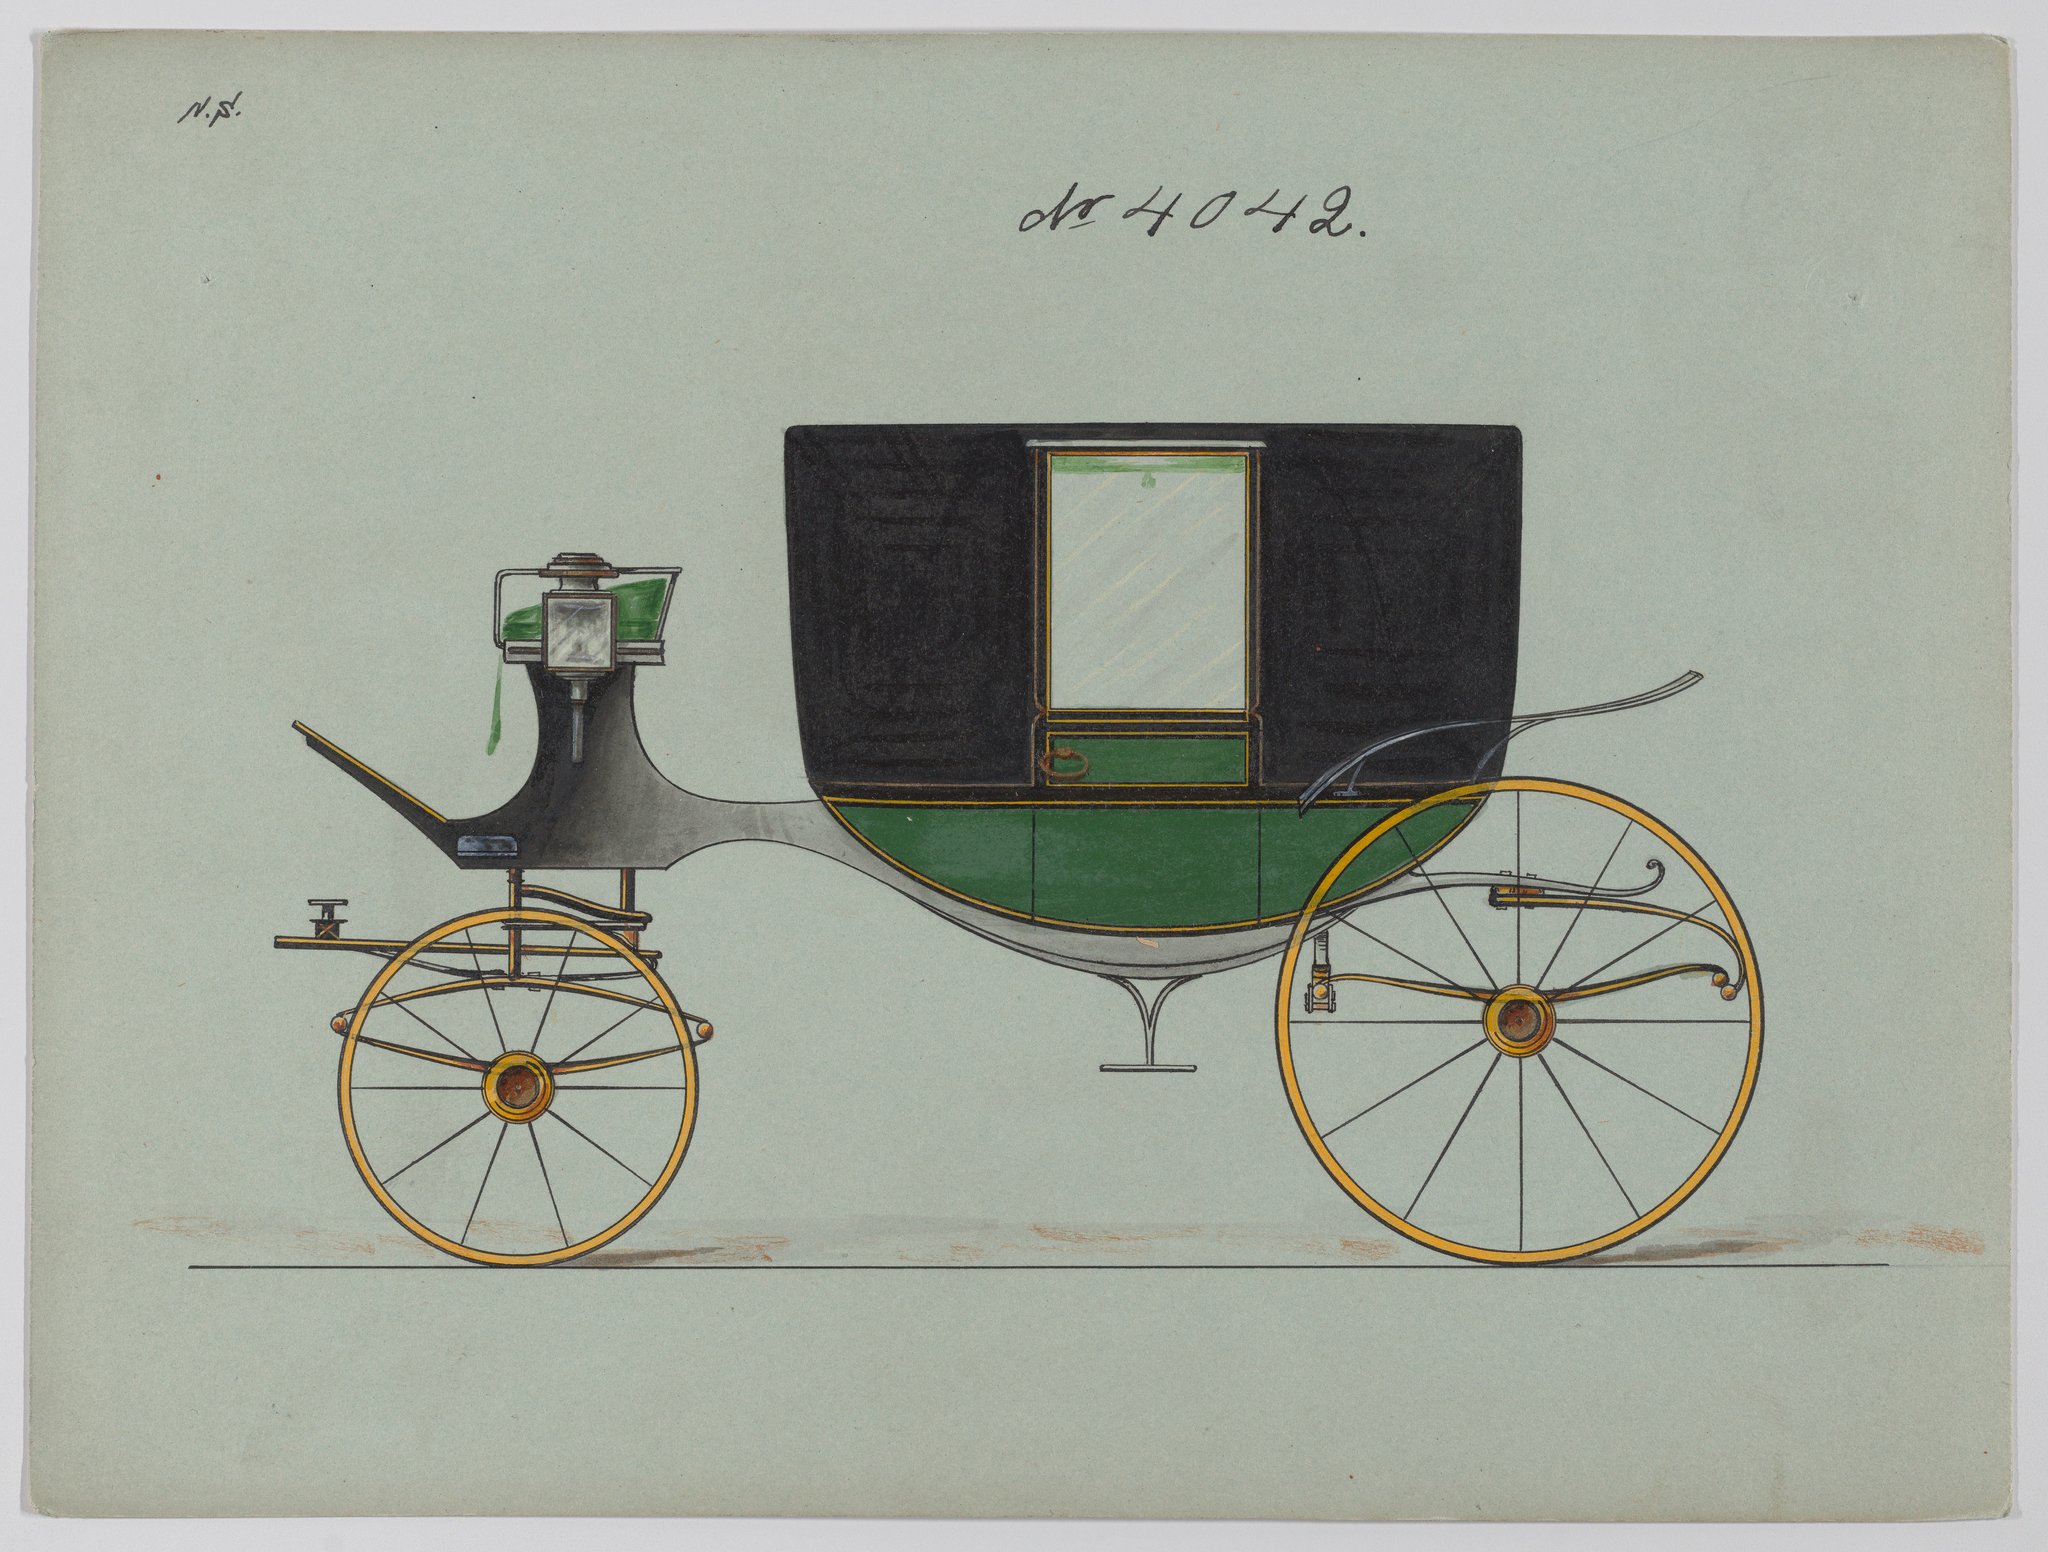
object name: drawing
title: Design for Landau, No. 4042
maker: brewster & co.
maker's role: manufacturer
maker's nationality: american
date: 1889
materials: gouache, gum arabic, ink, watercolor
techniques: pen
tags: carriages